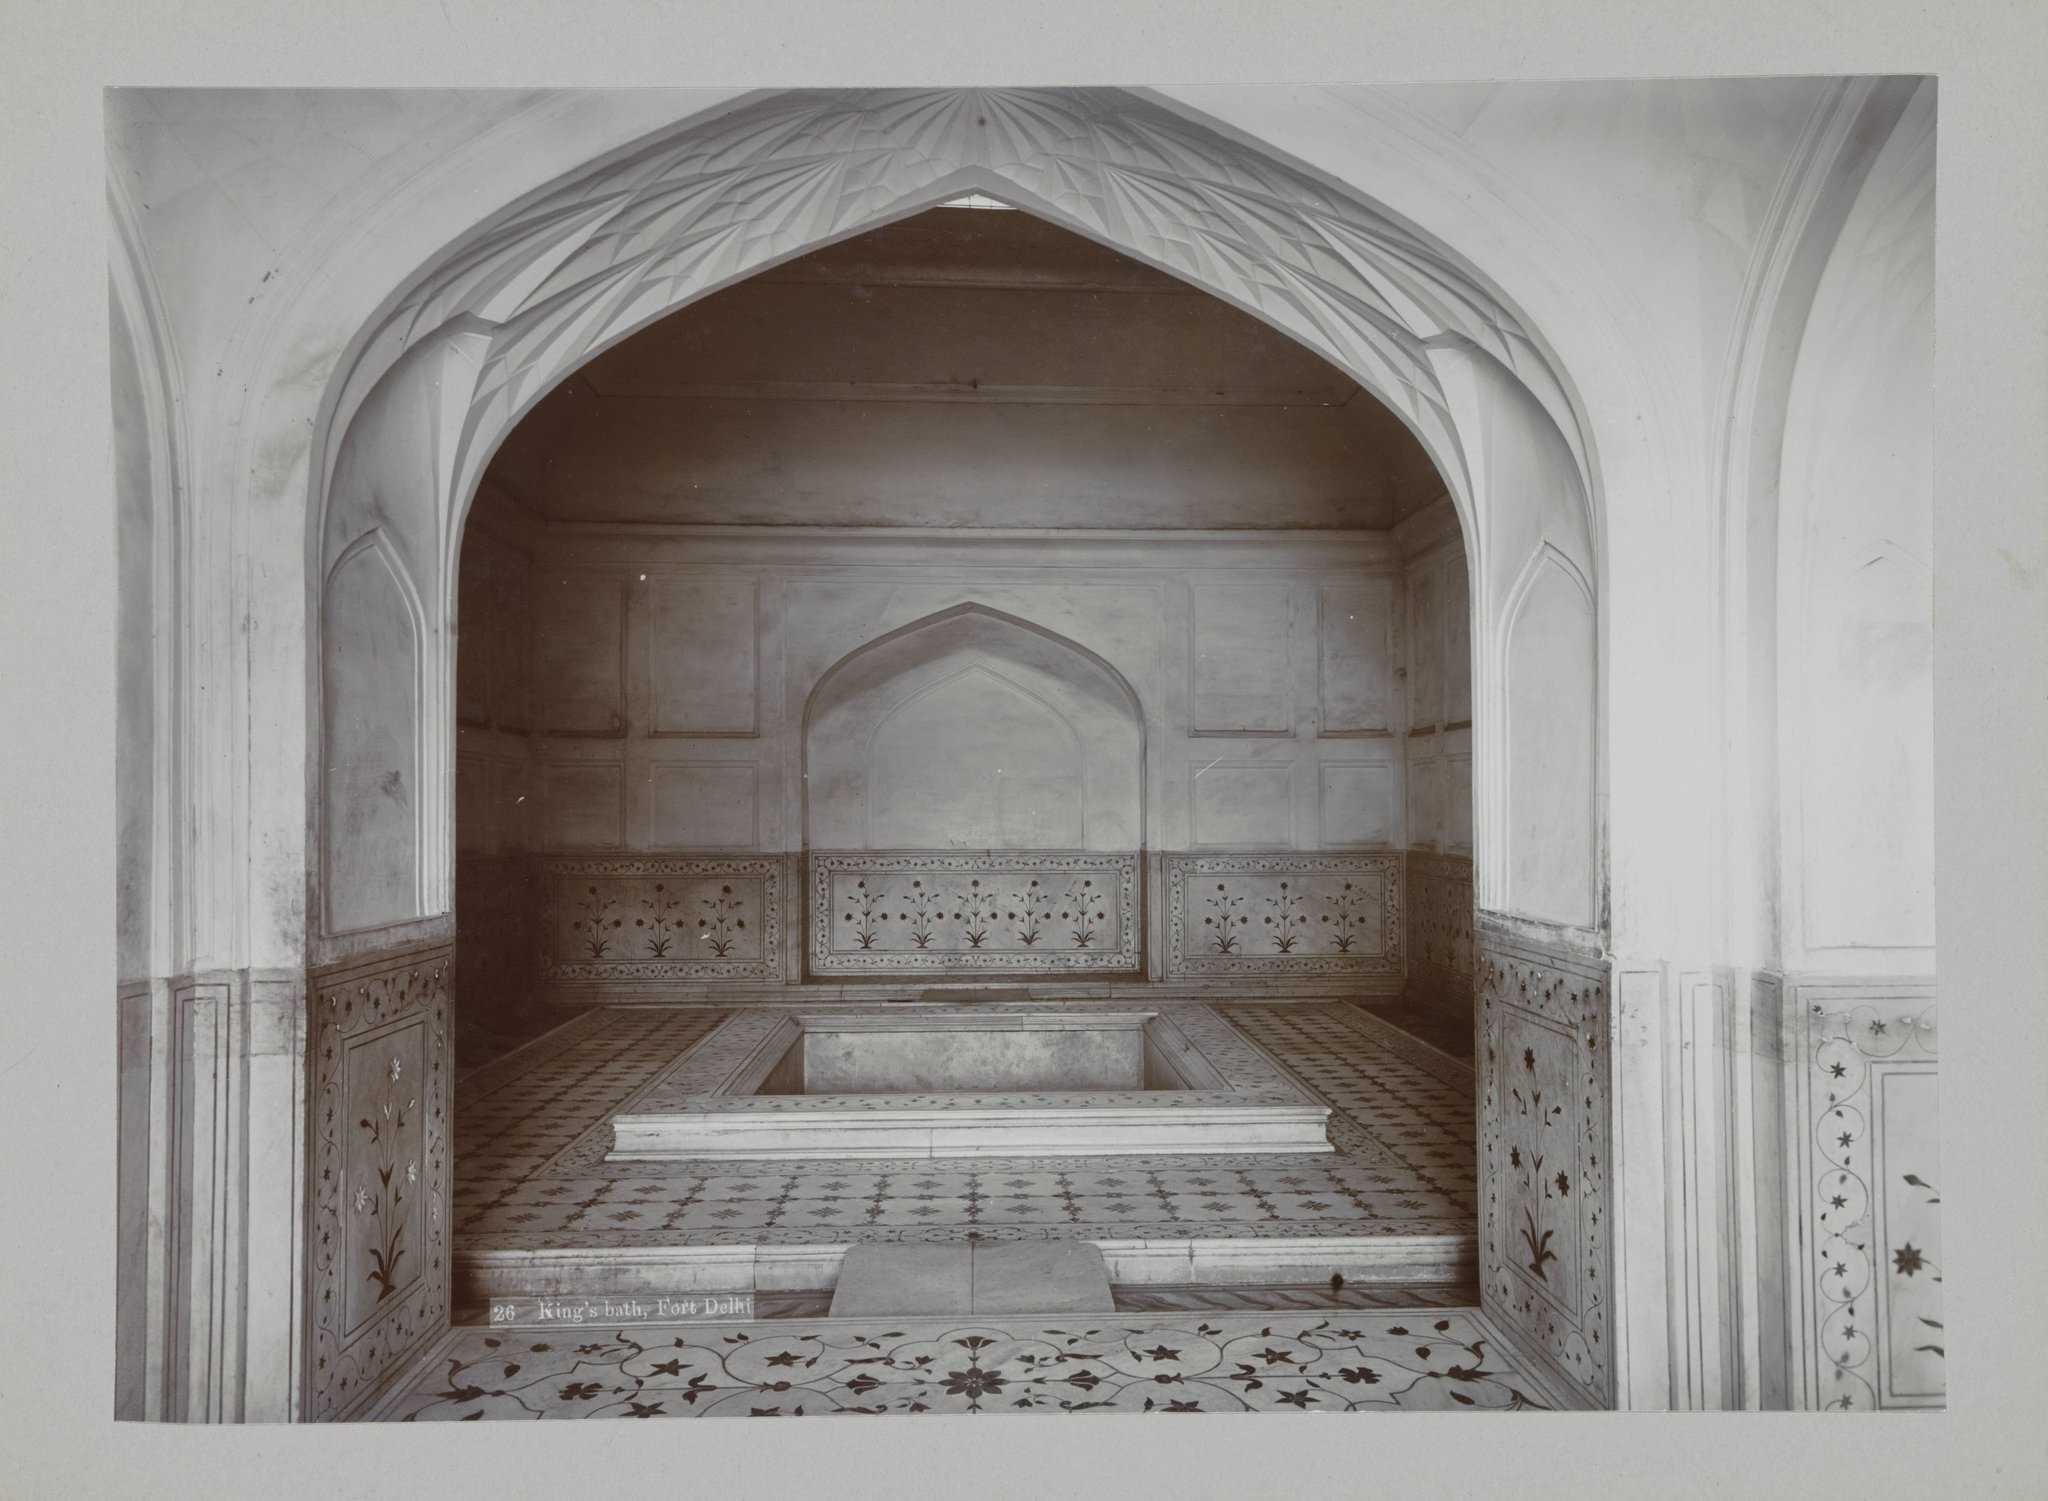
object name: photograph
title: The emperor's hammam within the Red Fort at Delhi, India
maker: Anonymous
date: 1895-1915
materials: cardboard, paper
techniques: gelatin silver print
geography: delhi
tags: delhi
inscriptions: number: ‘29.’, inscription: ‘26 Kings's bath, Fort Delhi’